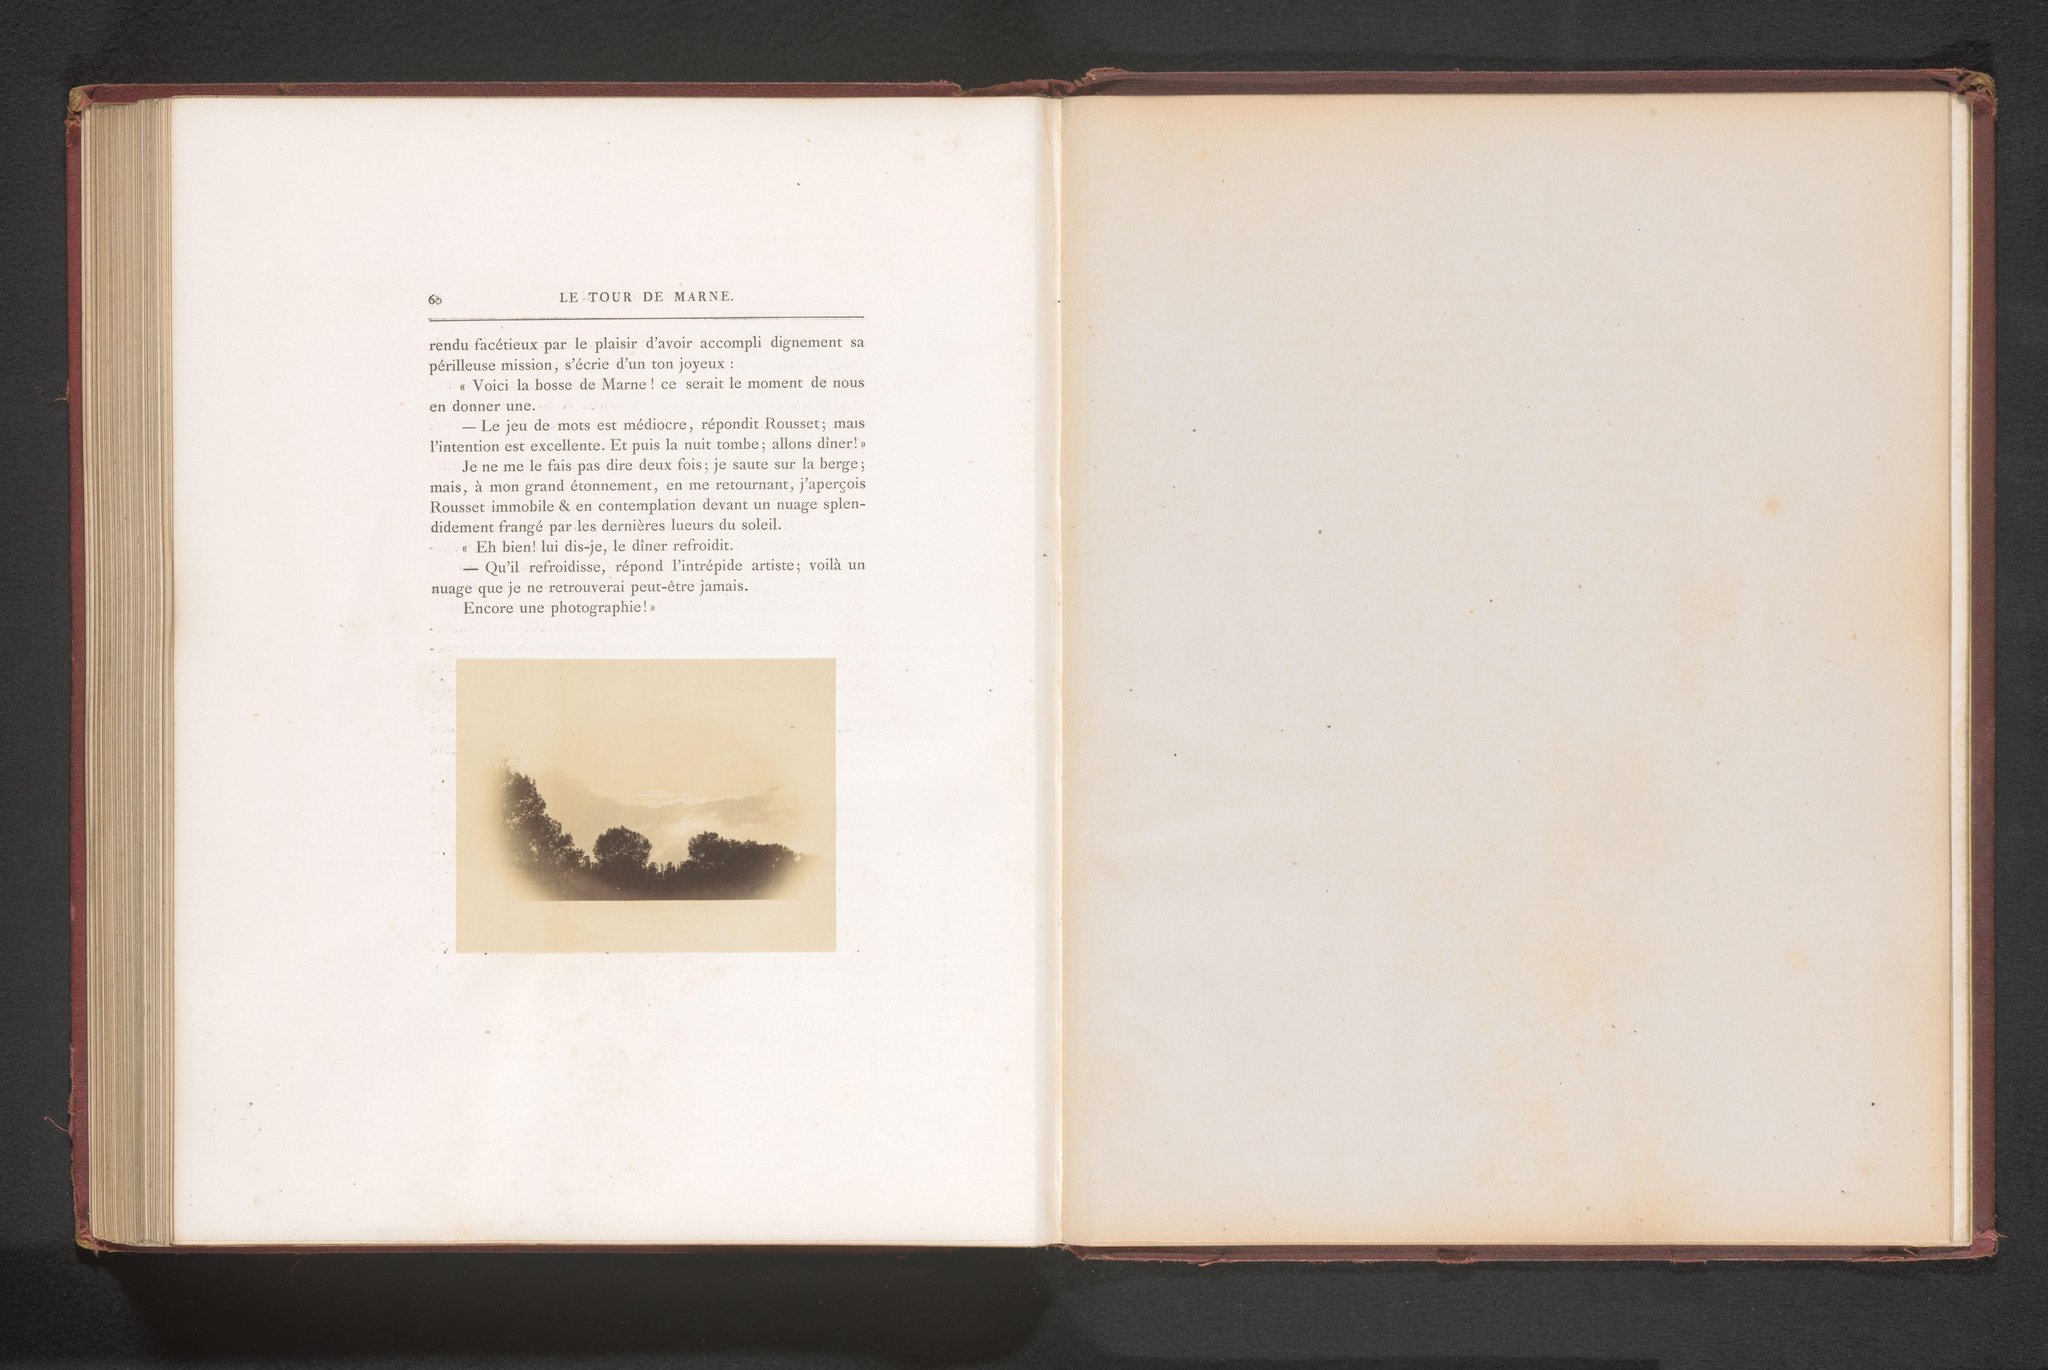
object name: page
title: Zonsondergang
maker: ildefonse rousset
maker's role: fotograaf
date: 1860-1865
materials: photographic support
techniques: albumen print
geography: france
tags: sunset